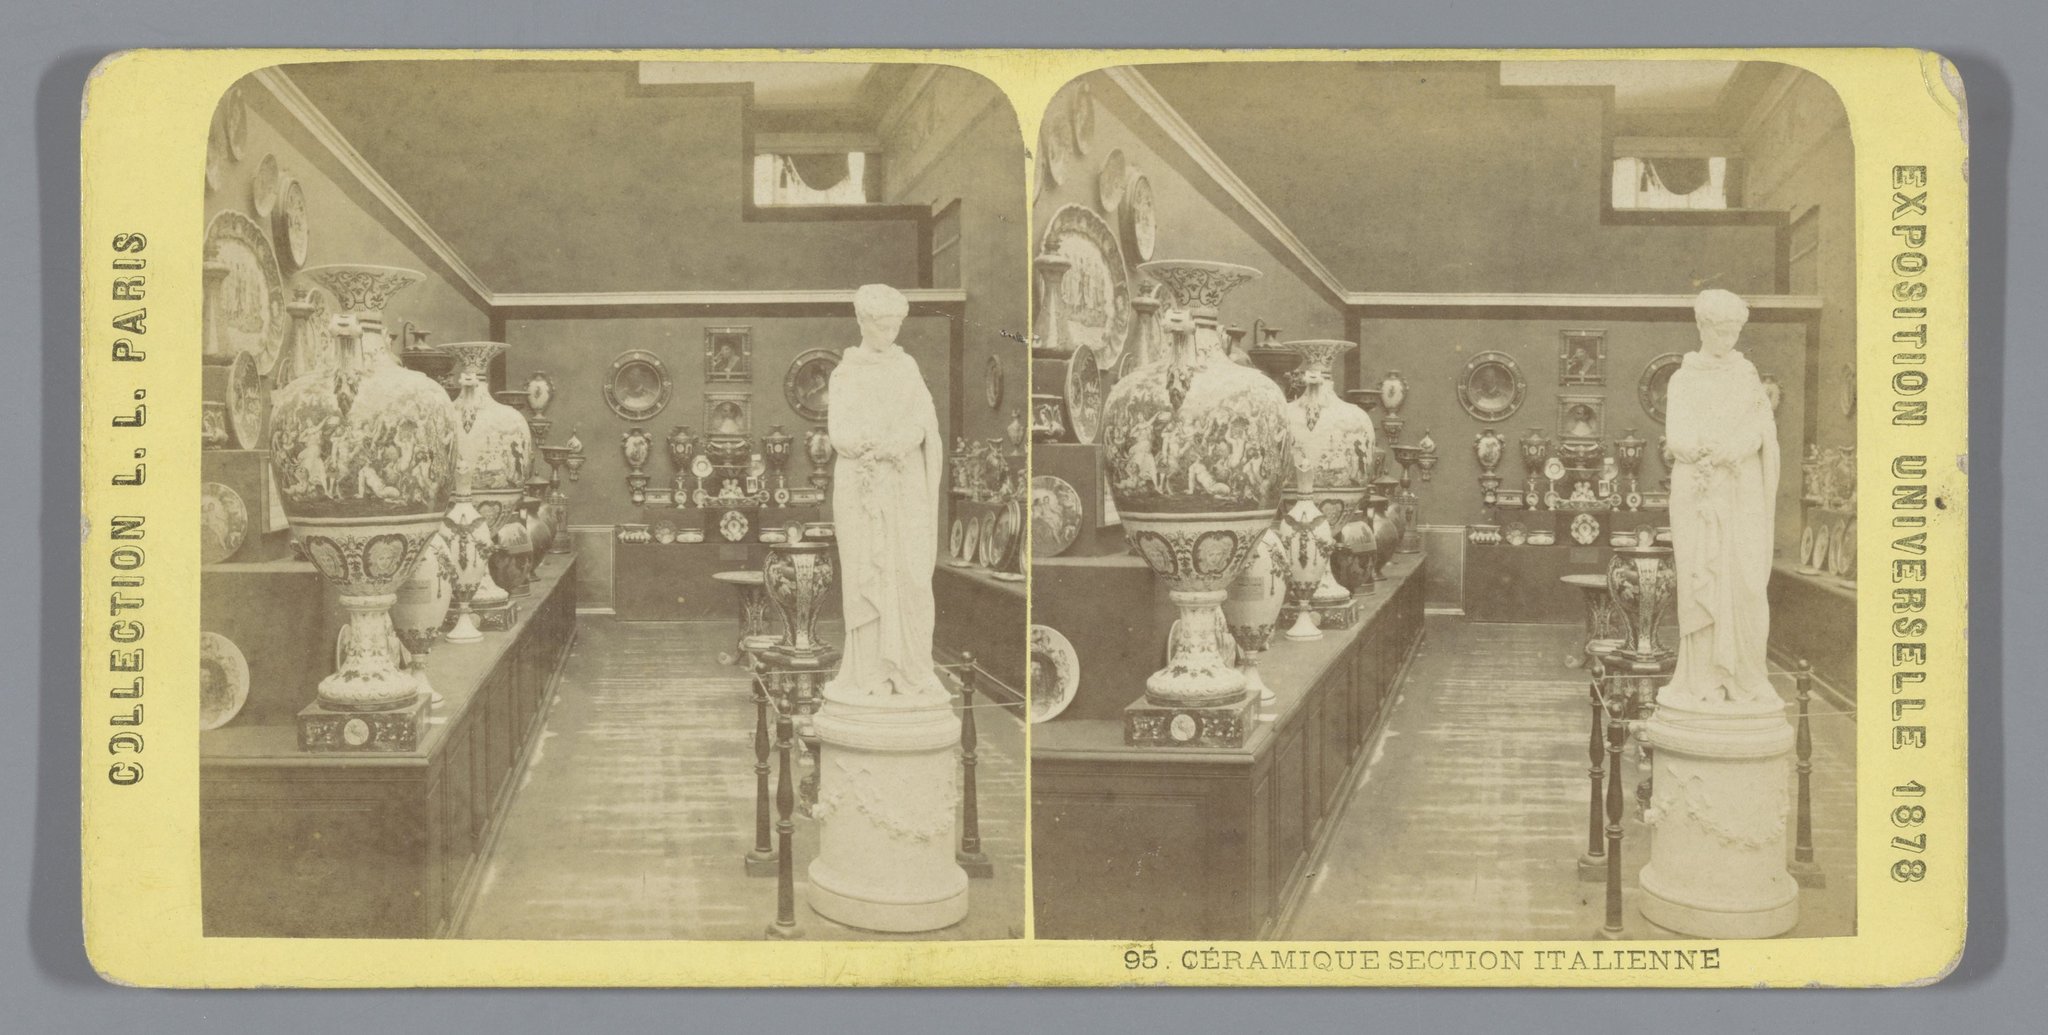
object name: stereograph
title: Exposition Universelle 1878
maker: Anonymous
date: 1878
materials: cardboard, paper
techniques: albumen print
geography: paris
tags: world fair, world exhibition, piece of sculpture, reproduction of a piece of sculpture, container of ceramics: jar, jug, pot, vase, paris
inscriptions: number: ‘95.’